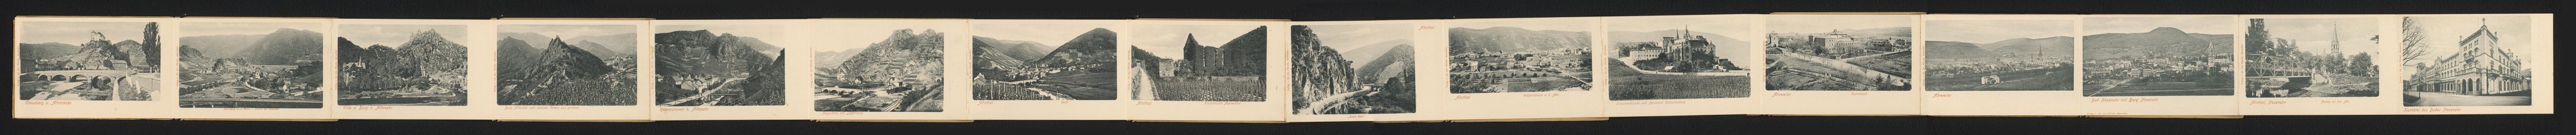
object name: accordion book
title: Das romantische Ahrthal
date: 1885-1903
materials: paper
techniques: photograph, printing block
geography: ahrtal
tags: bunch of grapes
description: Leporelloalbum met zestien prentbriefkaarten.